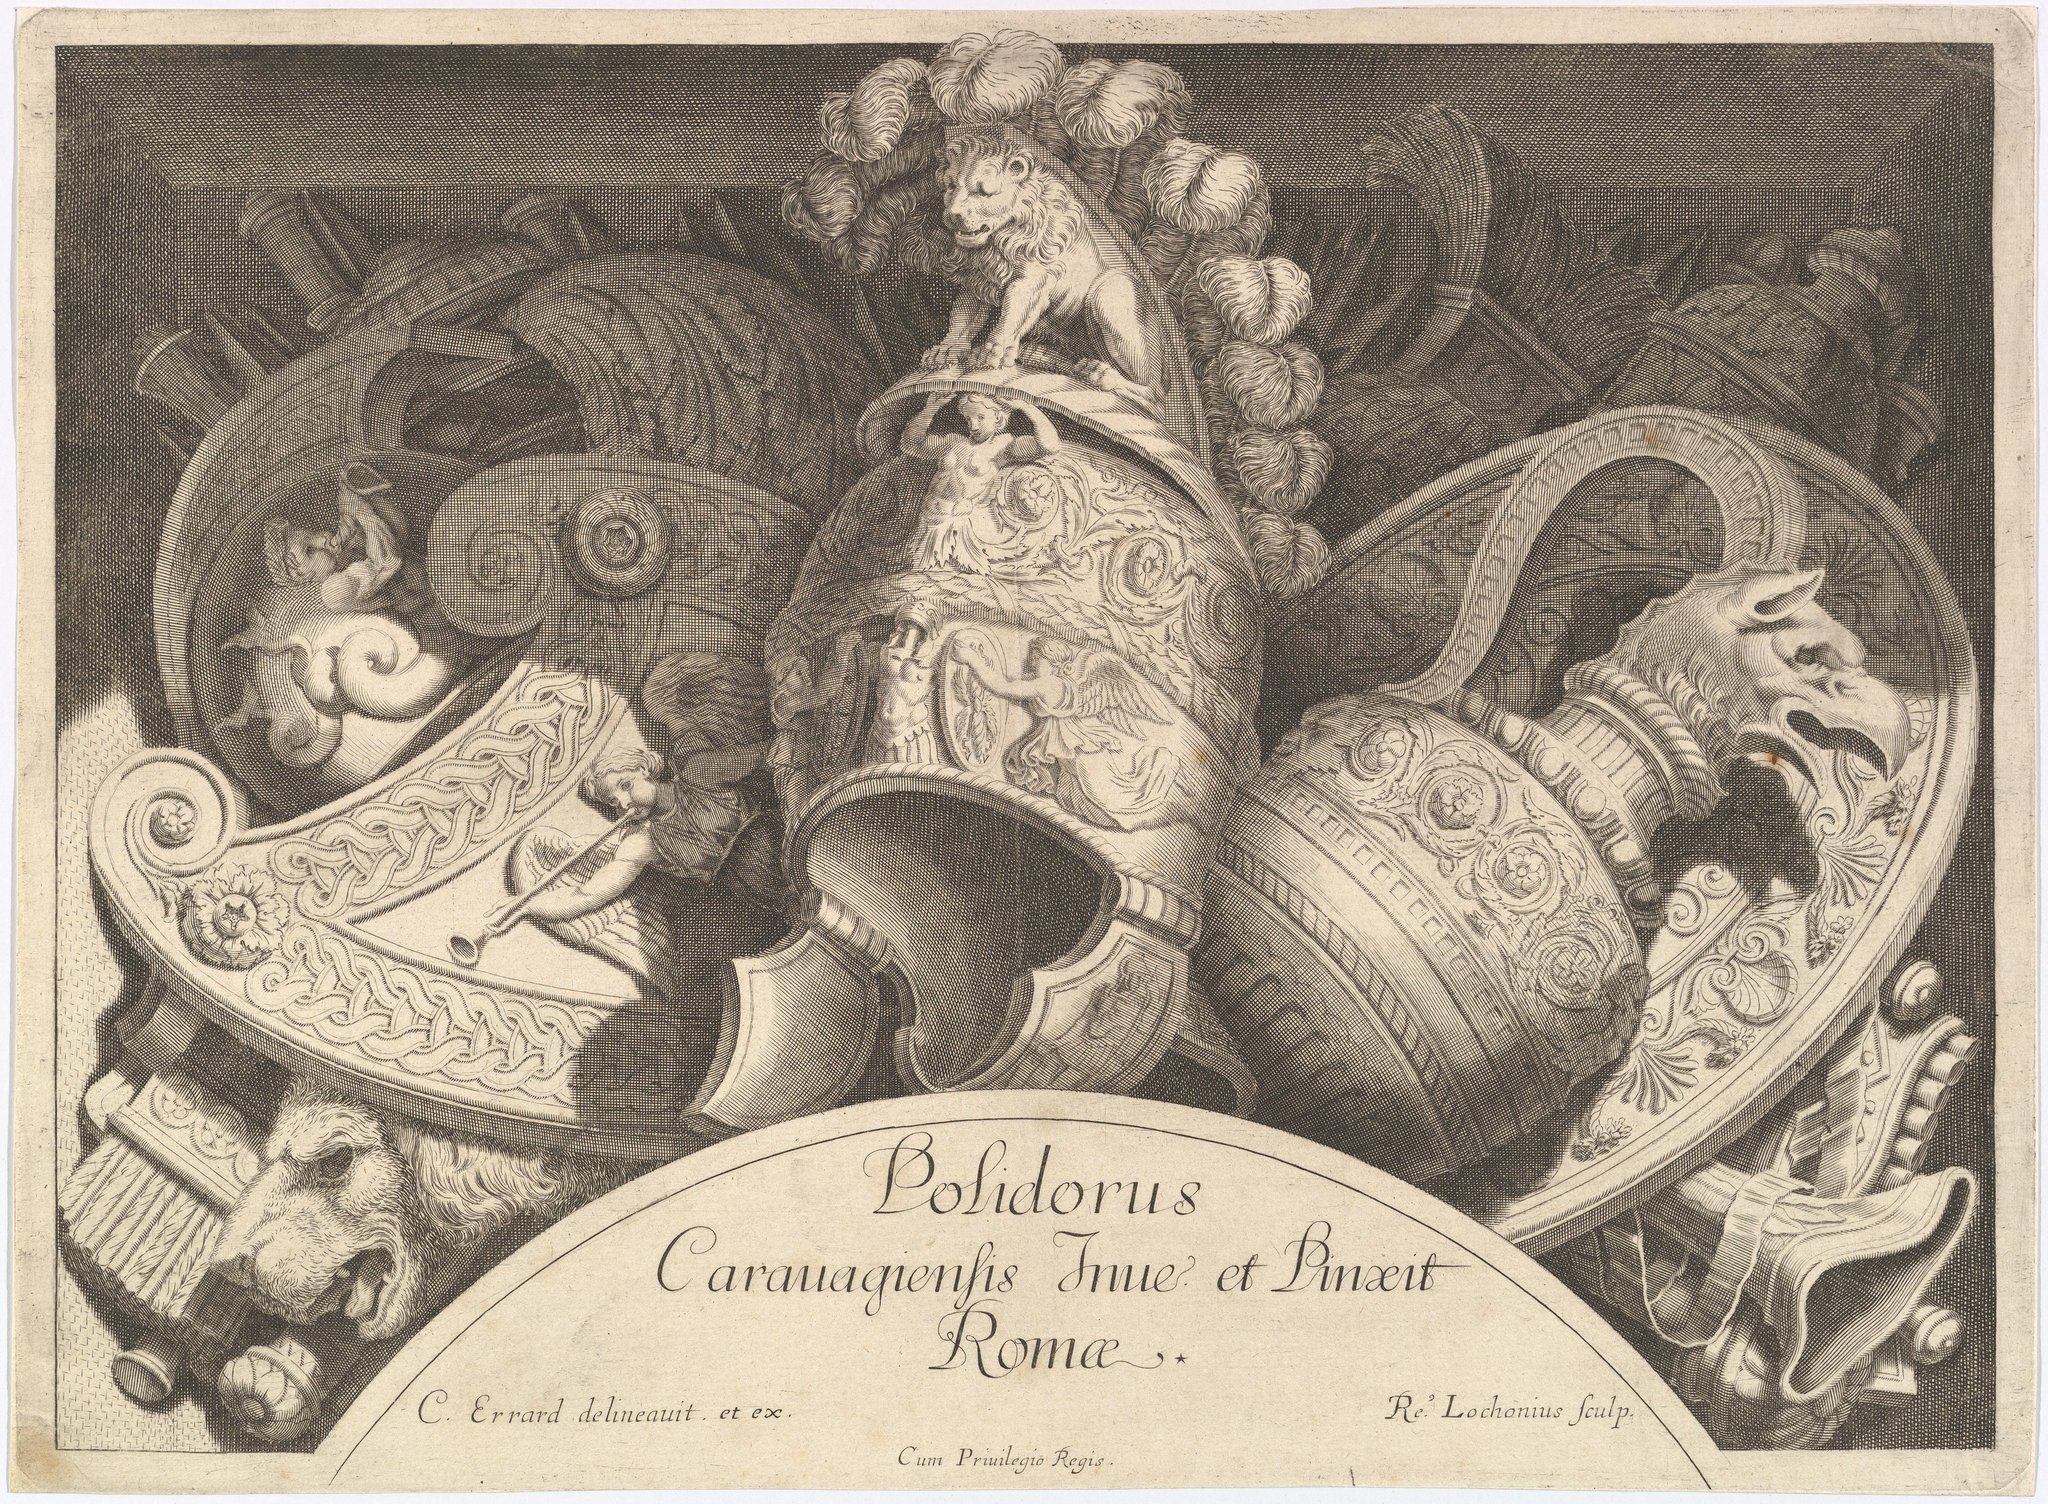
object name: print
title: Plate from "Divers Trophées" (Weapon Trophies after the Façade of Palazzo Milesi in Rome)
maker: polidoro da caravaggio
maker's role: artist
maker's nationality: italian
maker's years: 1494-1548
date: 1651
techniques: engraving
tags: animals,helmets,weapons